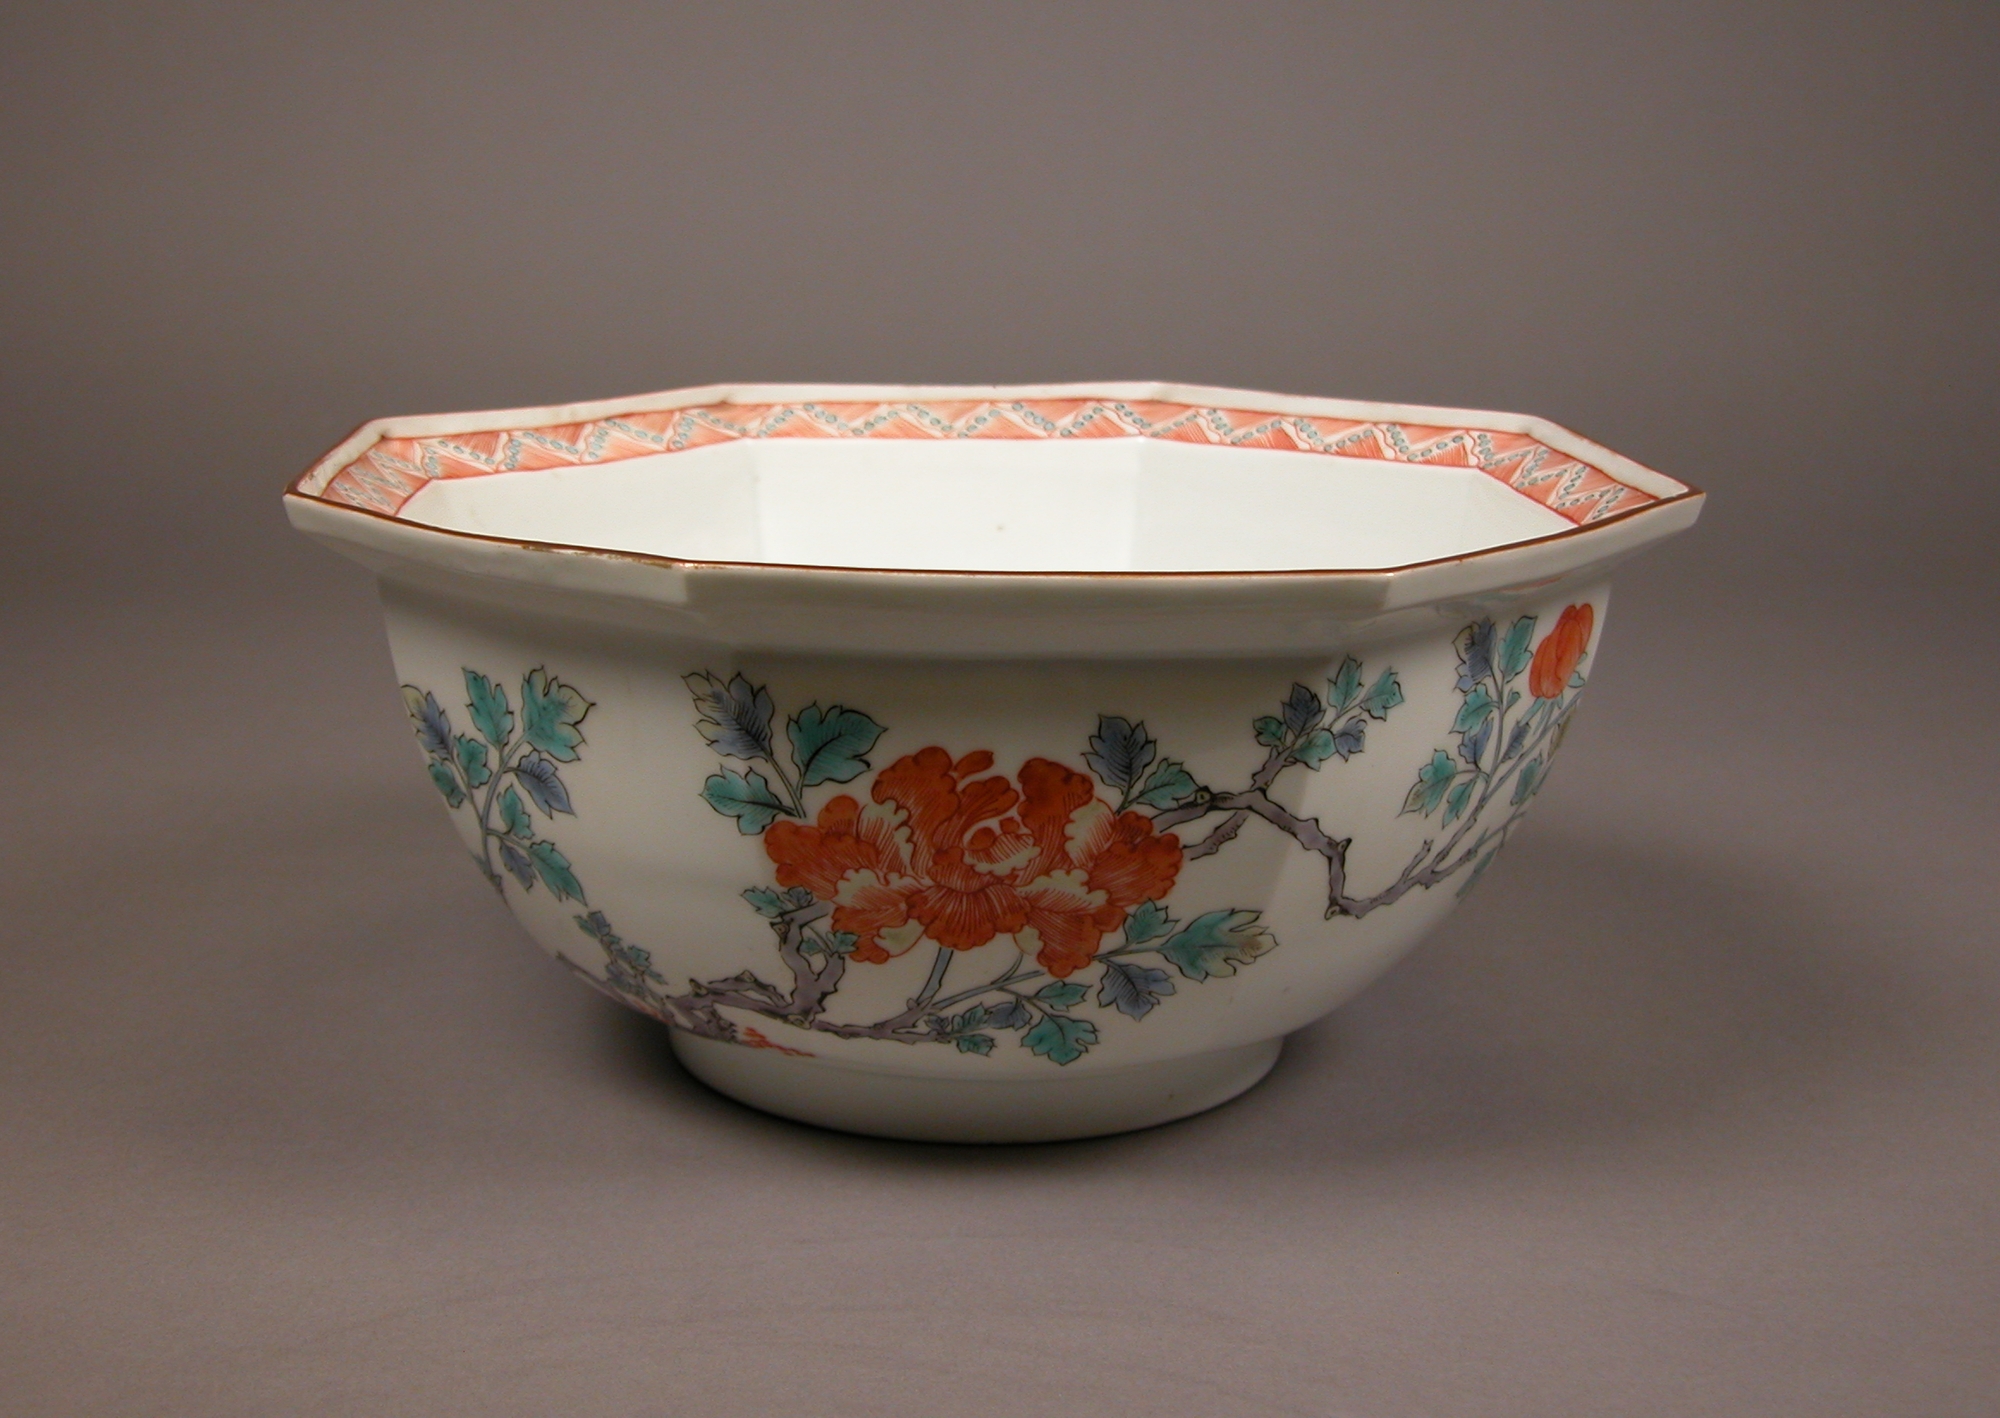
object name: bowl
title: Octagonal Bowl with Design of Peonies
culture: japanese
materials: enamel, porcelain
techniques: overglaze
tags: peonies,leaves